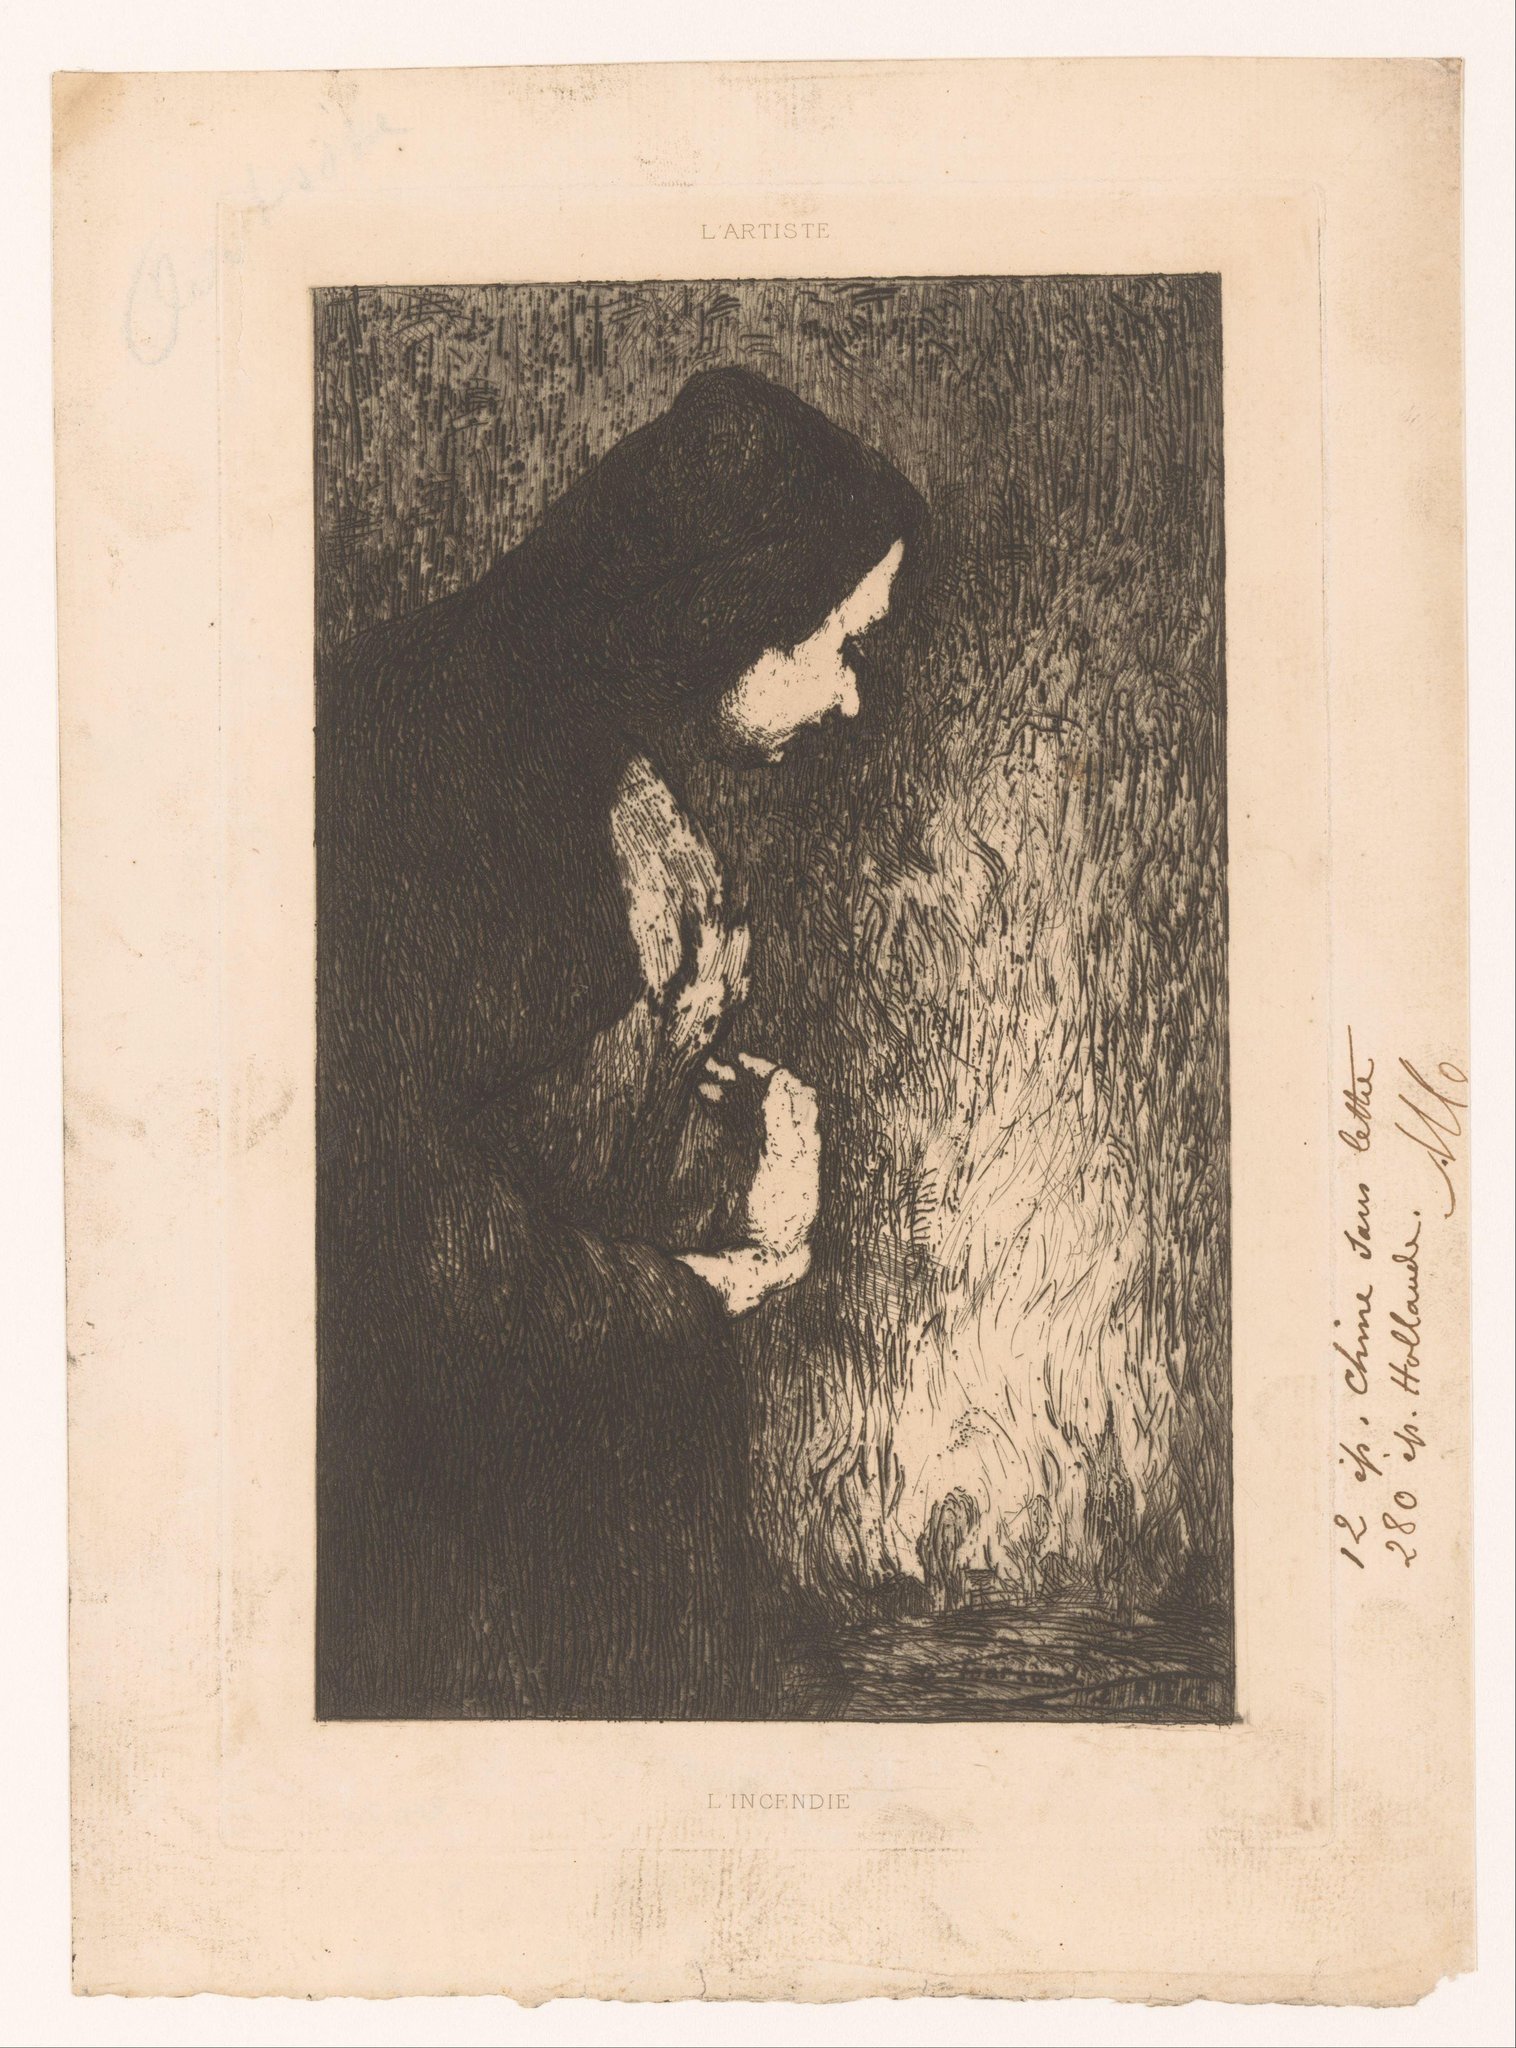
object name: print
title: L'Incendie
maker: théodule augustin ribot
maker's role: draughtsman, painter, print maker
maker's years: 1823-1891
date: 1833-1891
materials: paper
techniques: drypoint, etching, intaglio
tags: on fire, ablaze, adult woman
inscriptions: collector's mark: Lugt 2228, collector's mark: Lugt 2760